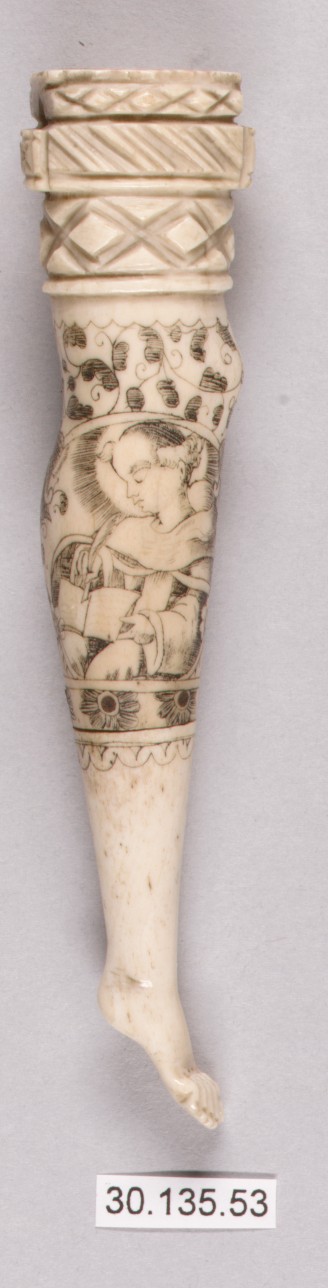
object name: needle case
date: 1601-1700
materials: ivory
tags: men,writing,legs